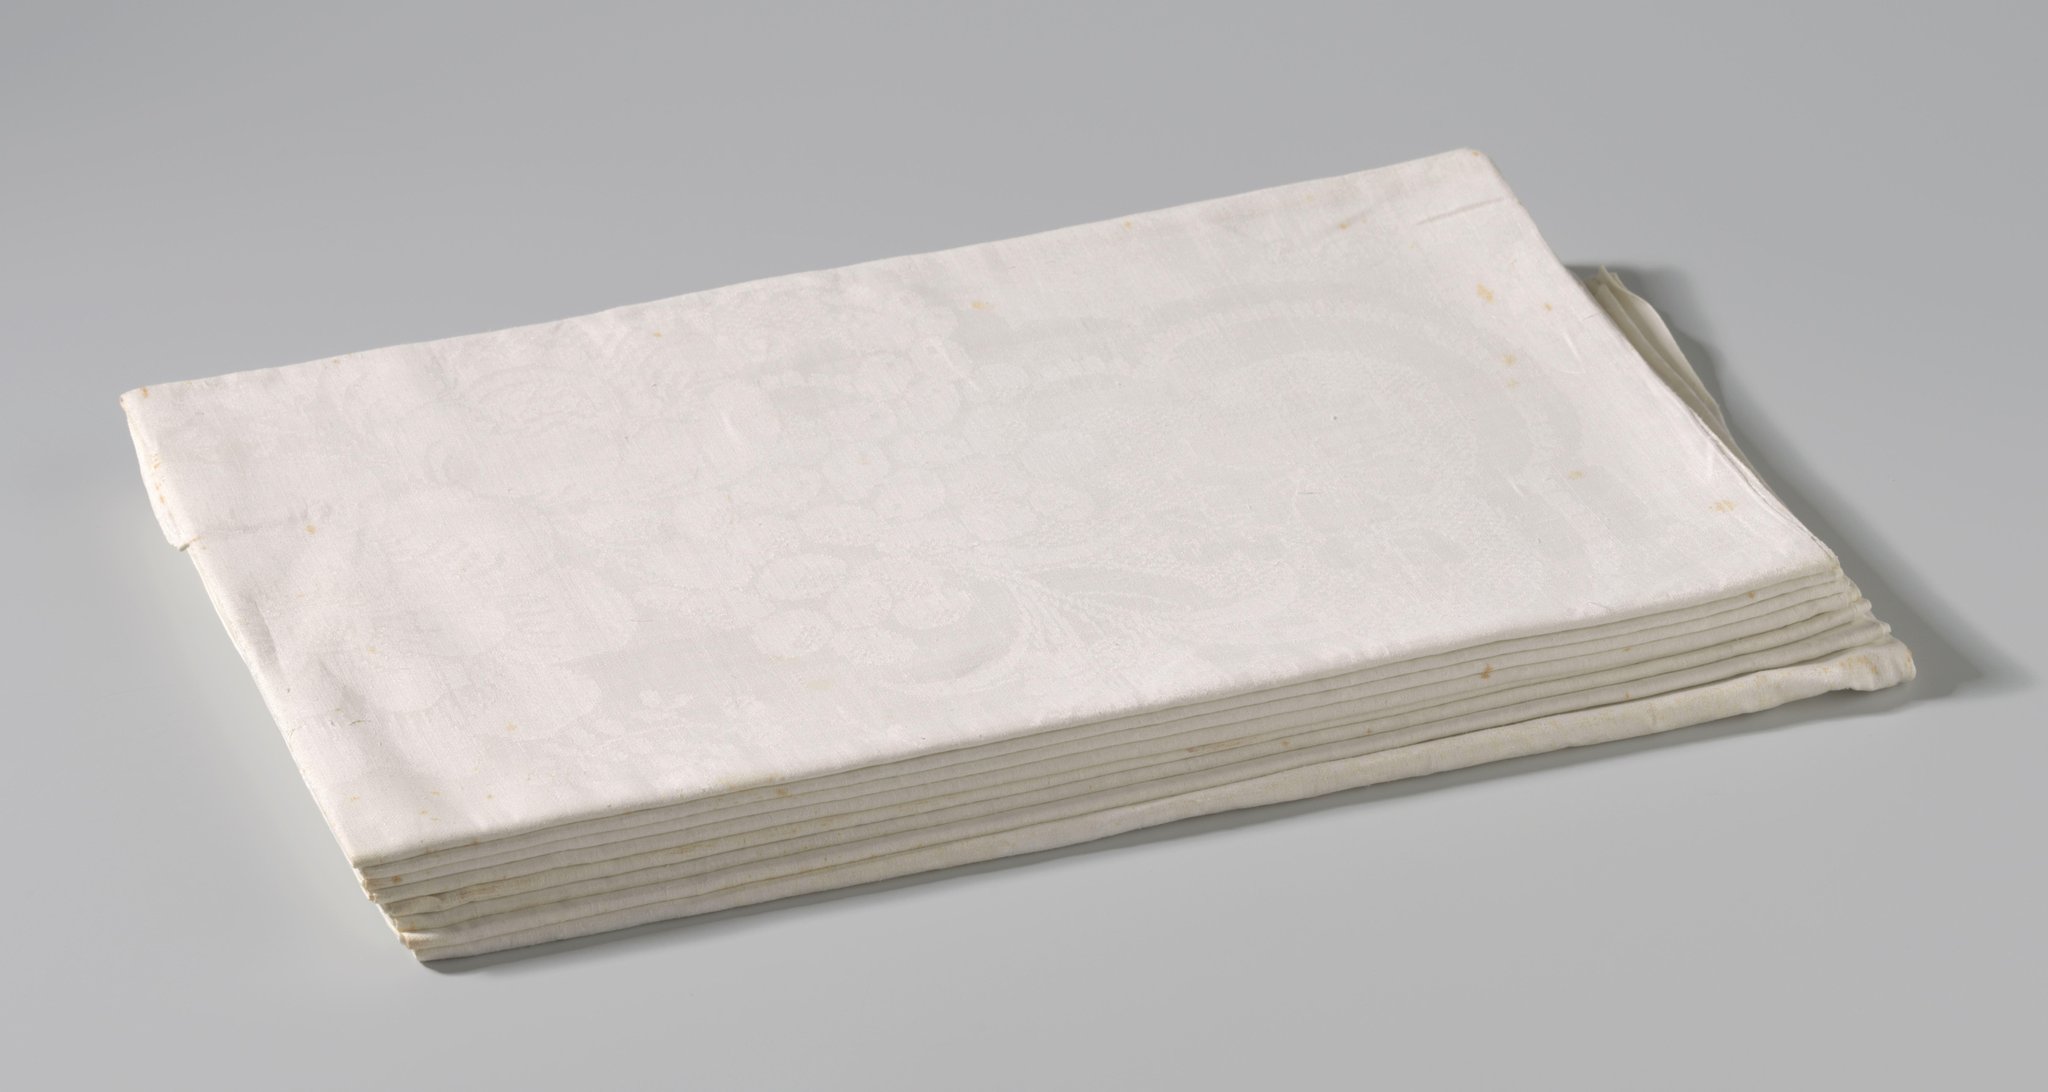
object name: tablecloth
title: Tafellaken van linnendamast met een bloempatroon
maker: Anonymous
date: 1740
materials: linen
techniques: damask, weave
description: Tafellaken van linnendamast met een bloempatroon. Bij het laken horen zes servetten (BK-1973-177-A t/m BK-1973-177-F).